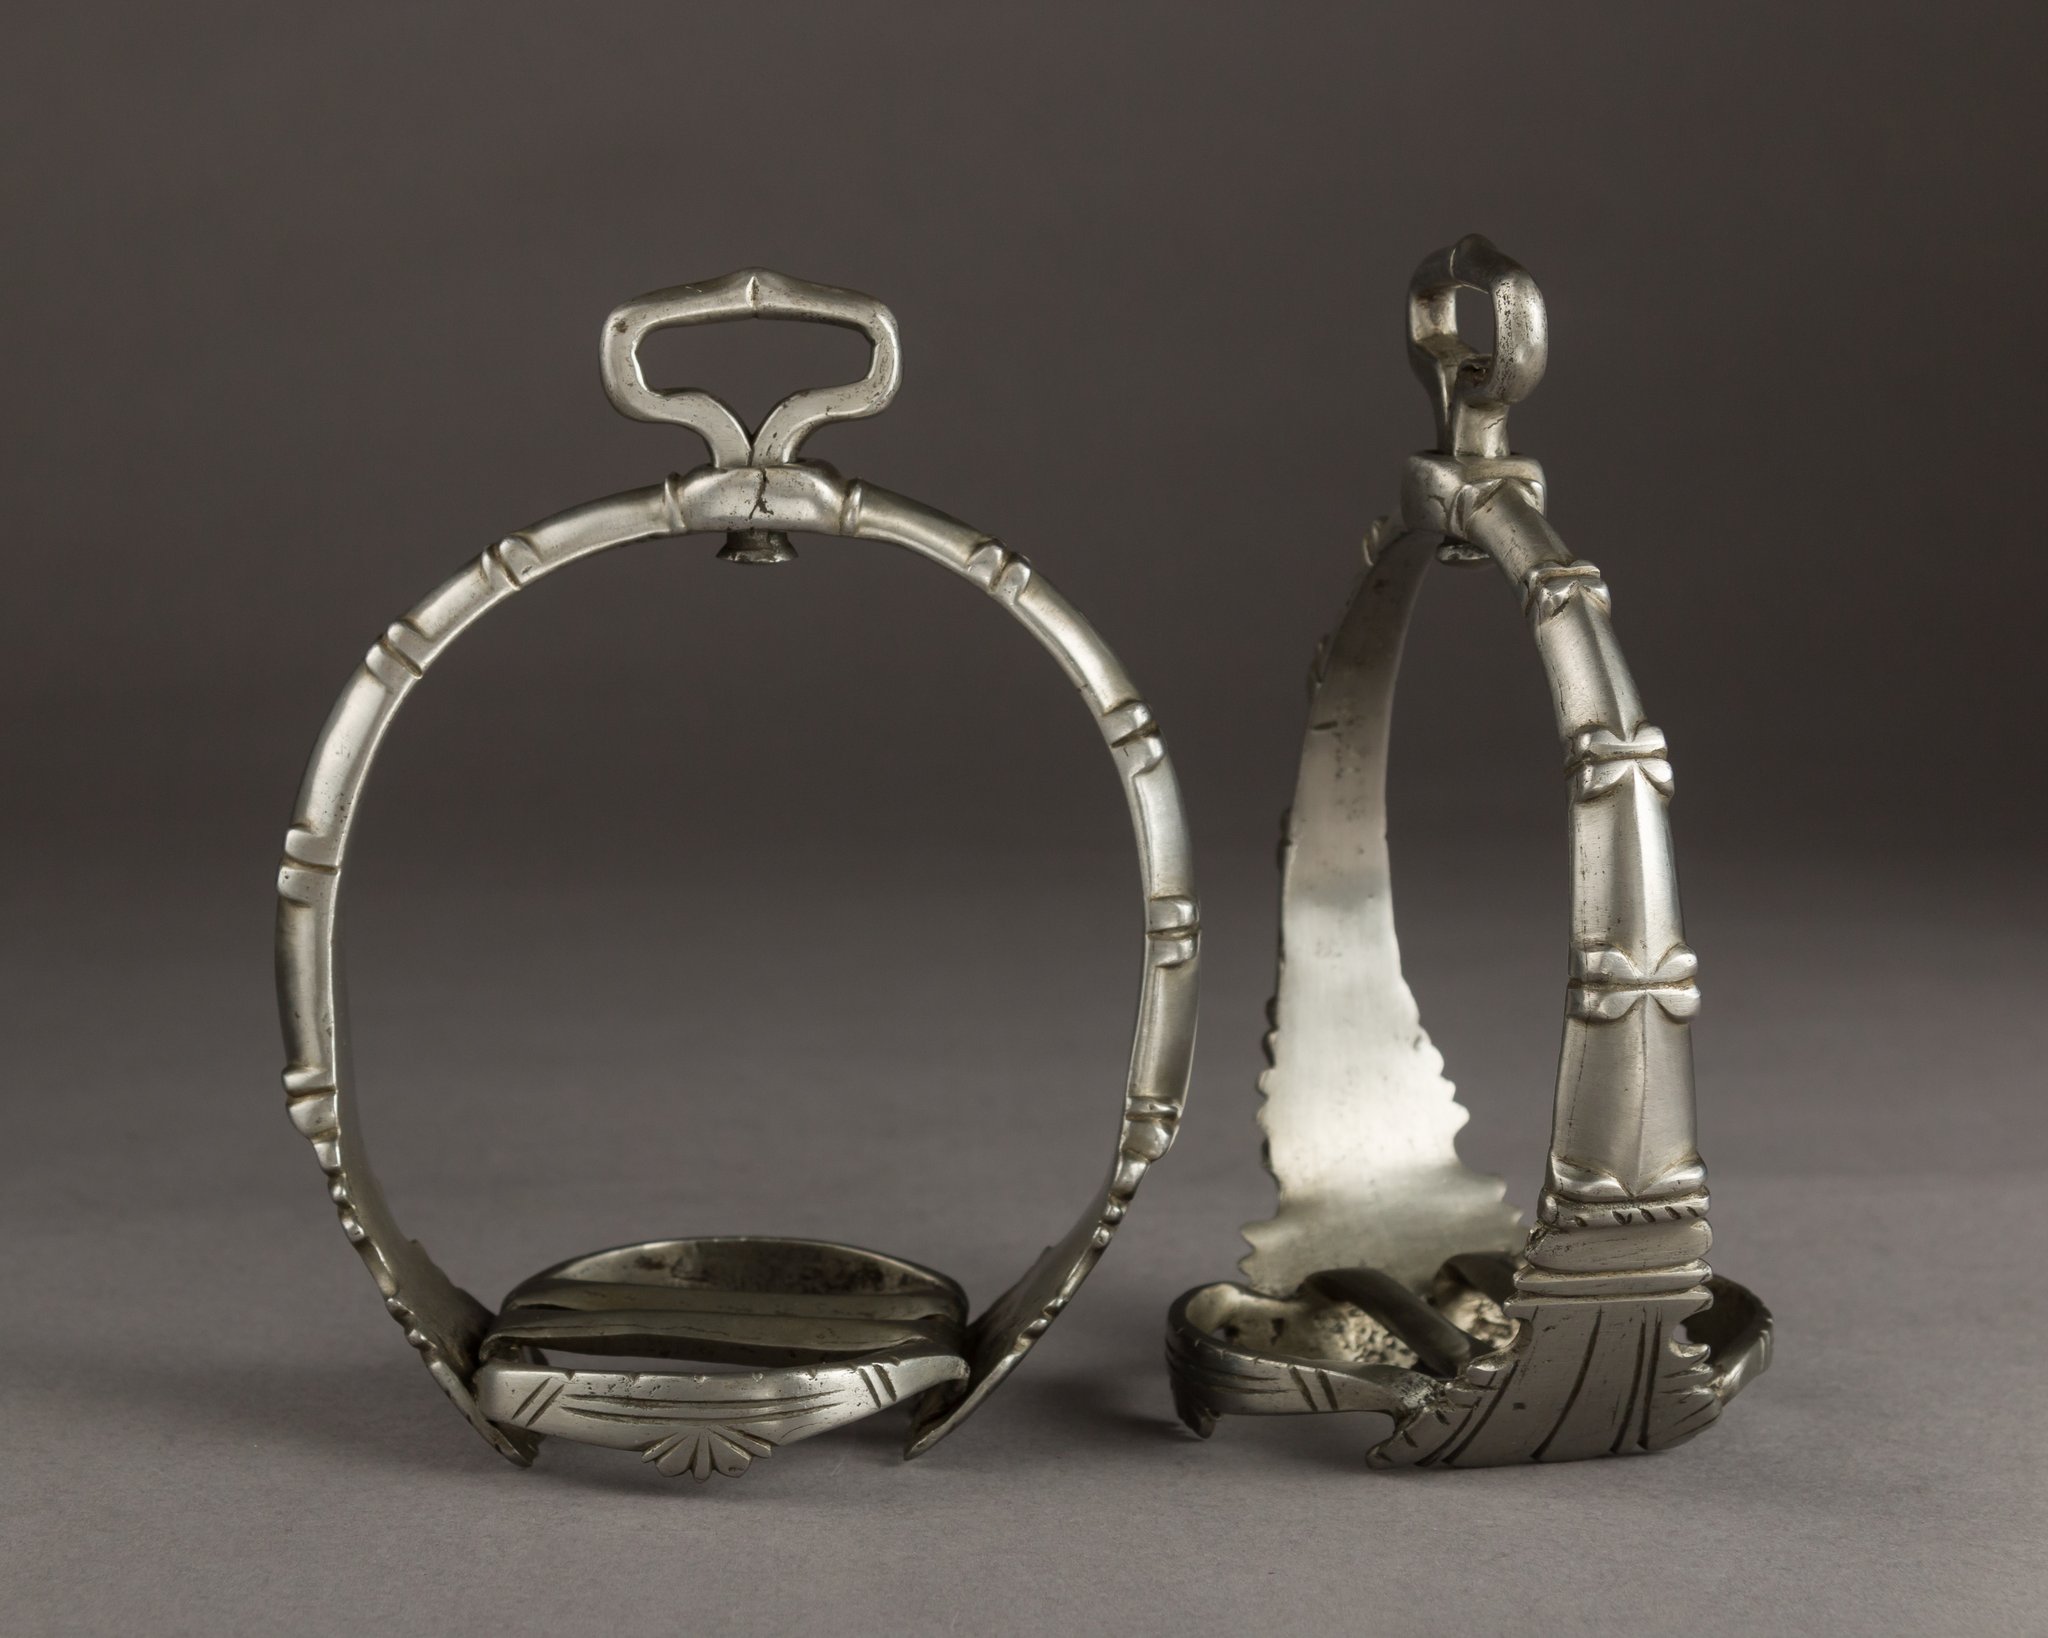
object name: stirrup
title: Pair of Stirrups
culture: dutch or german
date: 1660-1670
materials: metal alloy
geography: netherlands